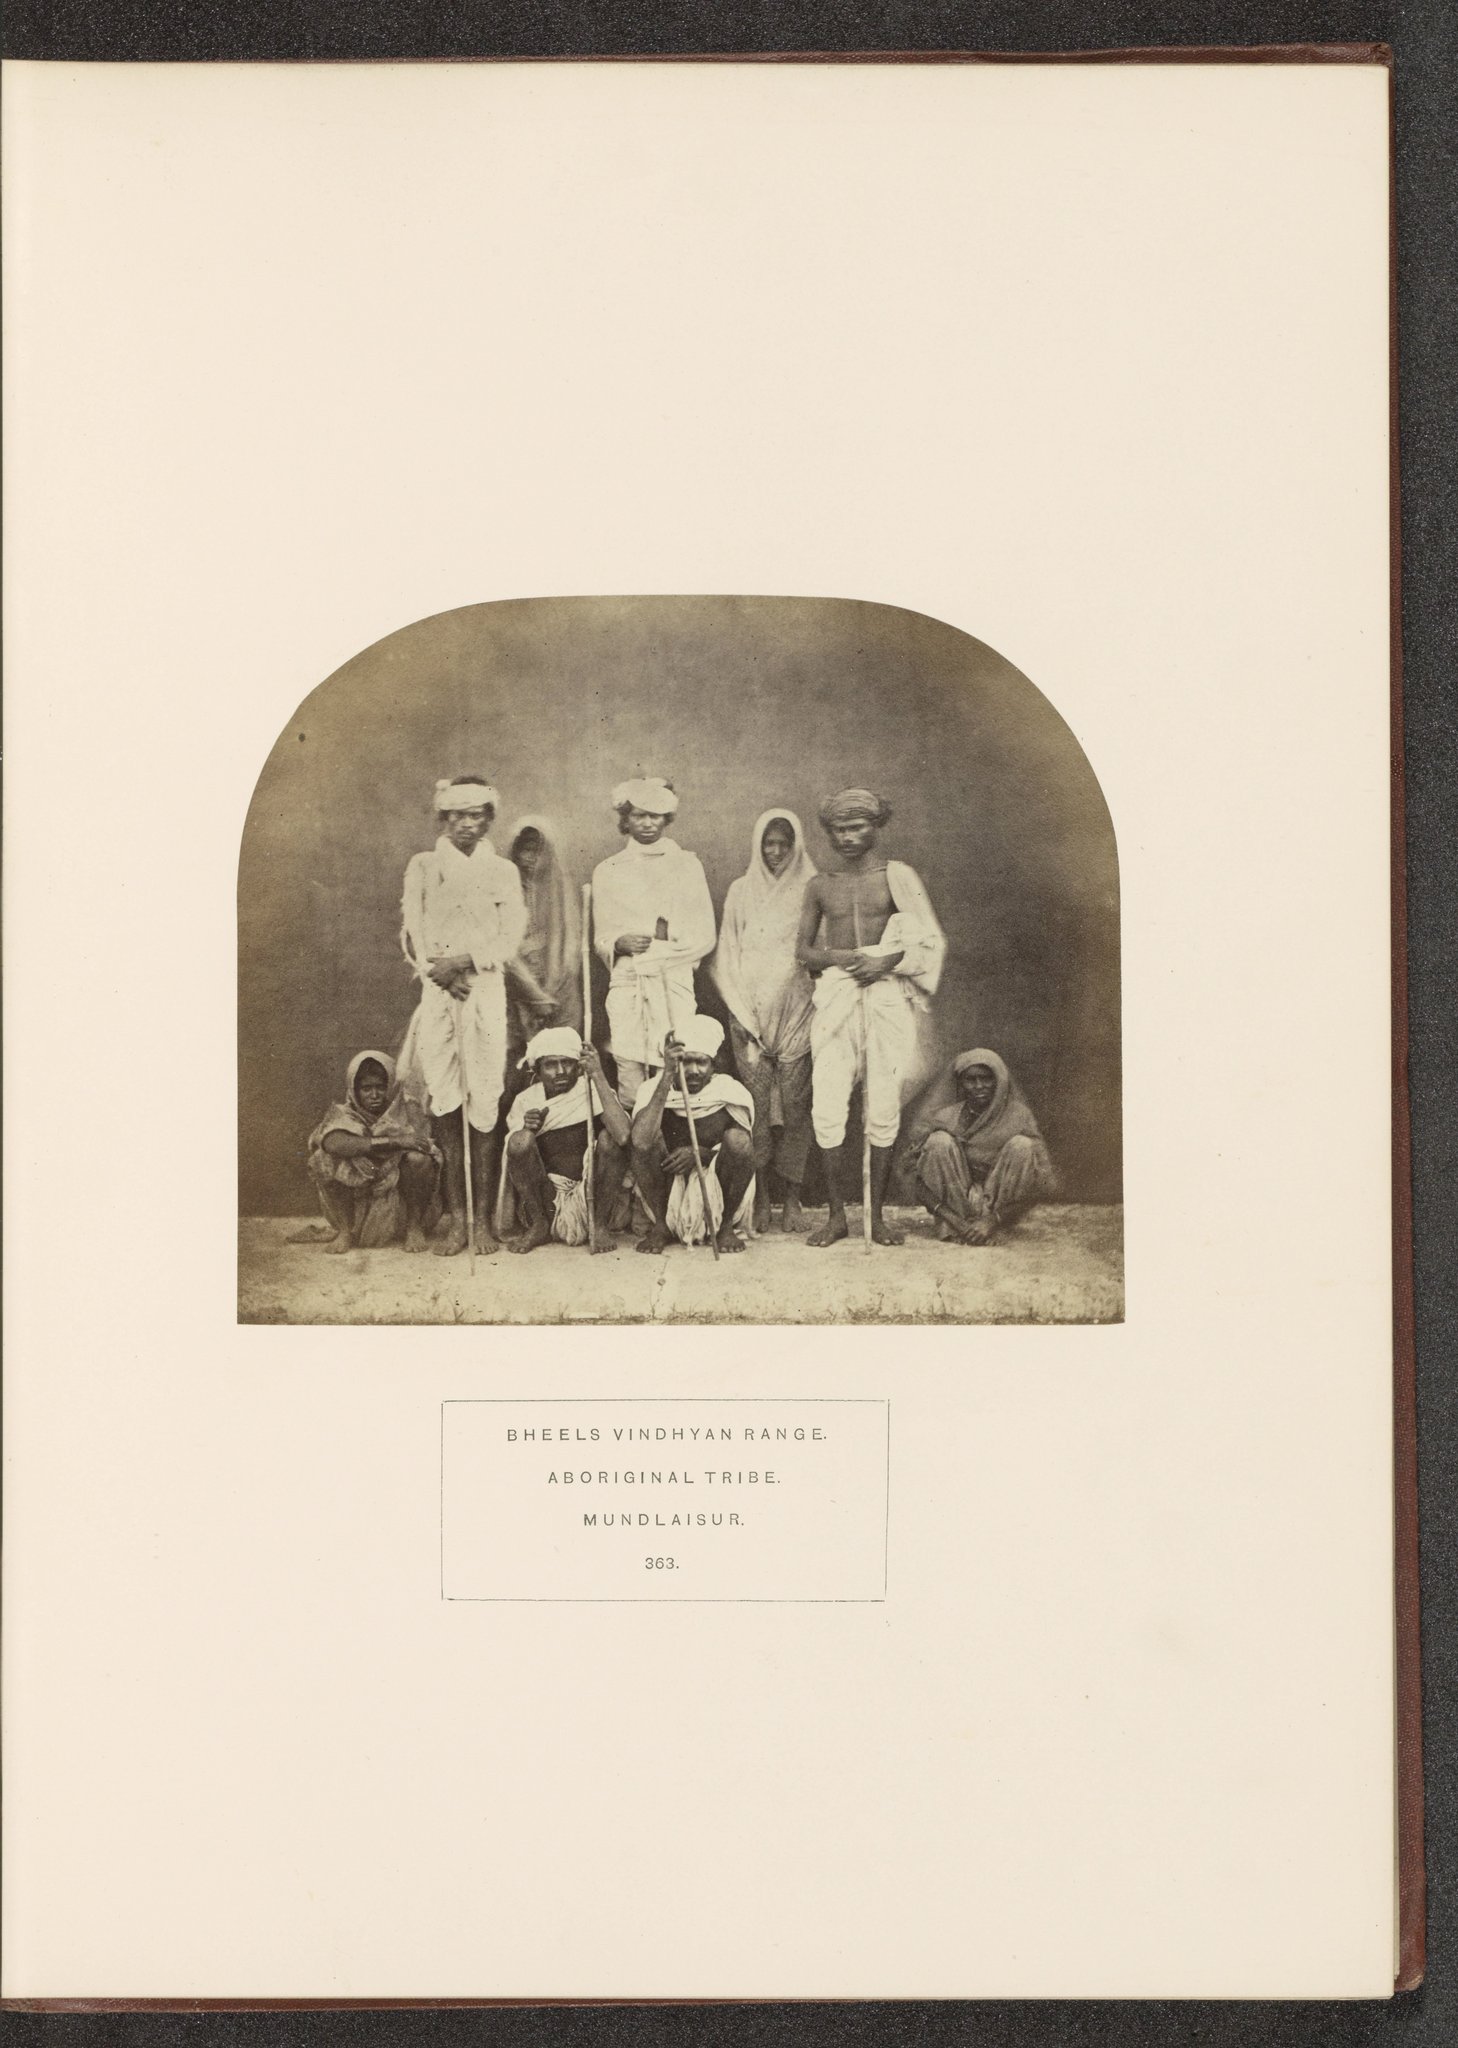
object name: photograph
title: Portrait of a group of people from the Bhil tribe of the Vindhya mountains, Mandleshwar, Madhya Pradesh, India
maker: james john waterhouse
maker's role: fotograaf, luitenant, officier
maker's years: 1842-1928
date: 1862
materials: photographic support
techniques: albumen print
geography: mandleshwar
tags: human races; peoples; nationalities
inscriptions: number: ‘363.’, inscription: ‘BHEELS VINDHYAN RANGE./ ABORIGINAL TRIBE./ MUNDLAISUR.’